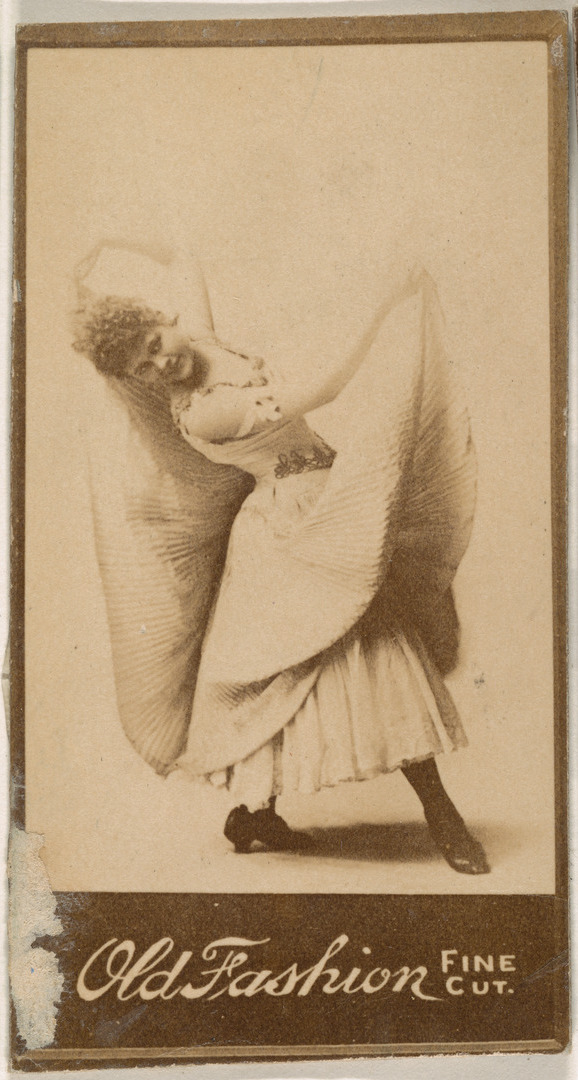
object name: photograph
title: Dancer, from the Actresses series (N664) promoting Old Fashion Fine Cut Tobacco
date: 1888-1890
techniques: albumen silver print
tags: portraits,women,dancers